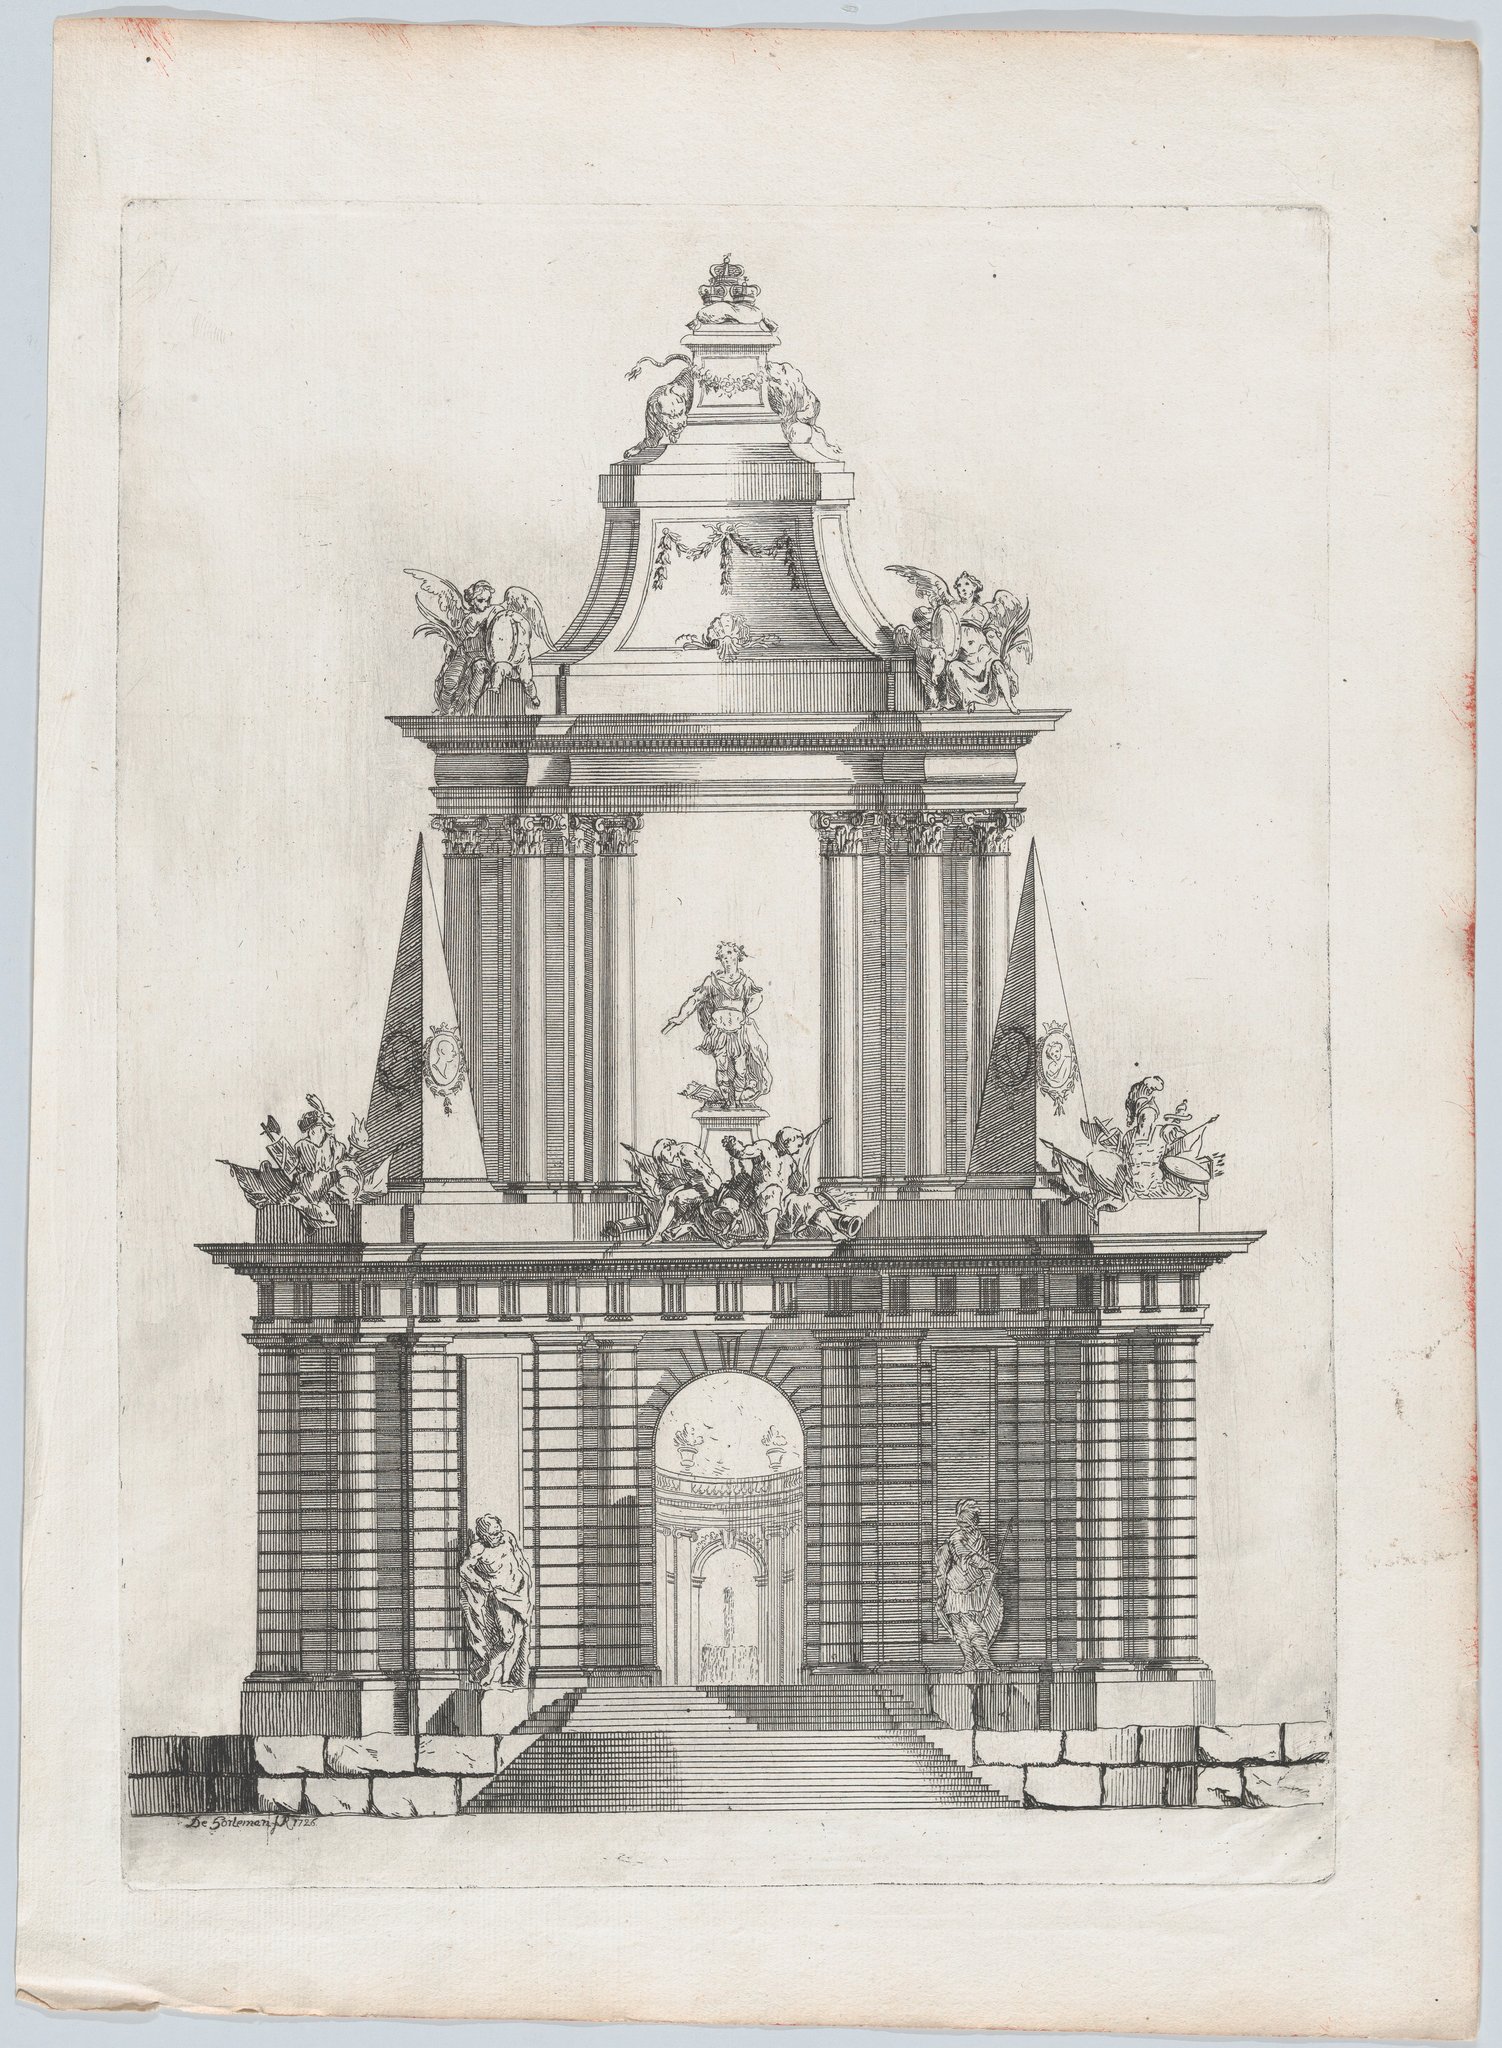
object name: print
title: Triumphal arch with three crowns at top, a fountain in the distance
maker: carl hårleman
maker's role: artist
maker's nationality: swedish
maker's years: 1700-1753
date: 1726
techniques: etching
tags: arches